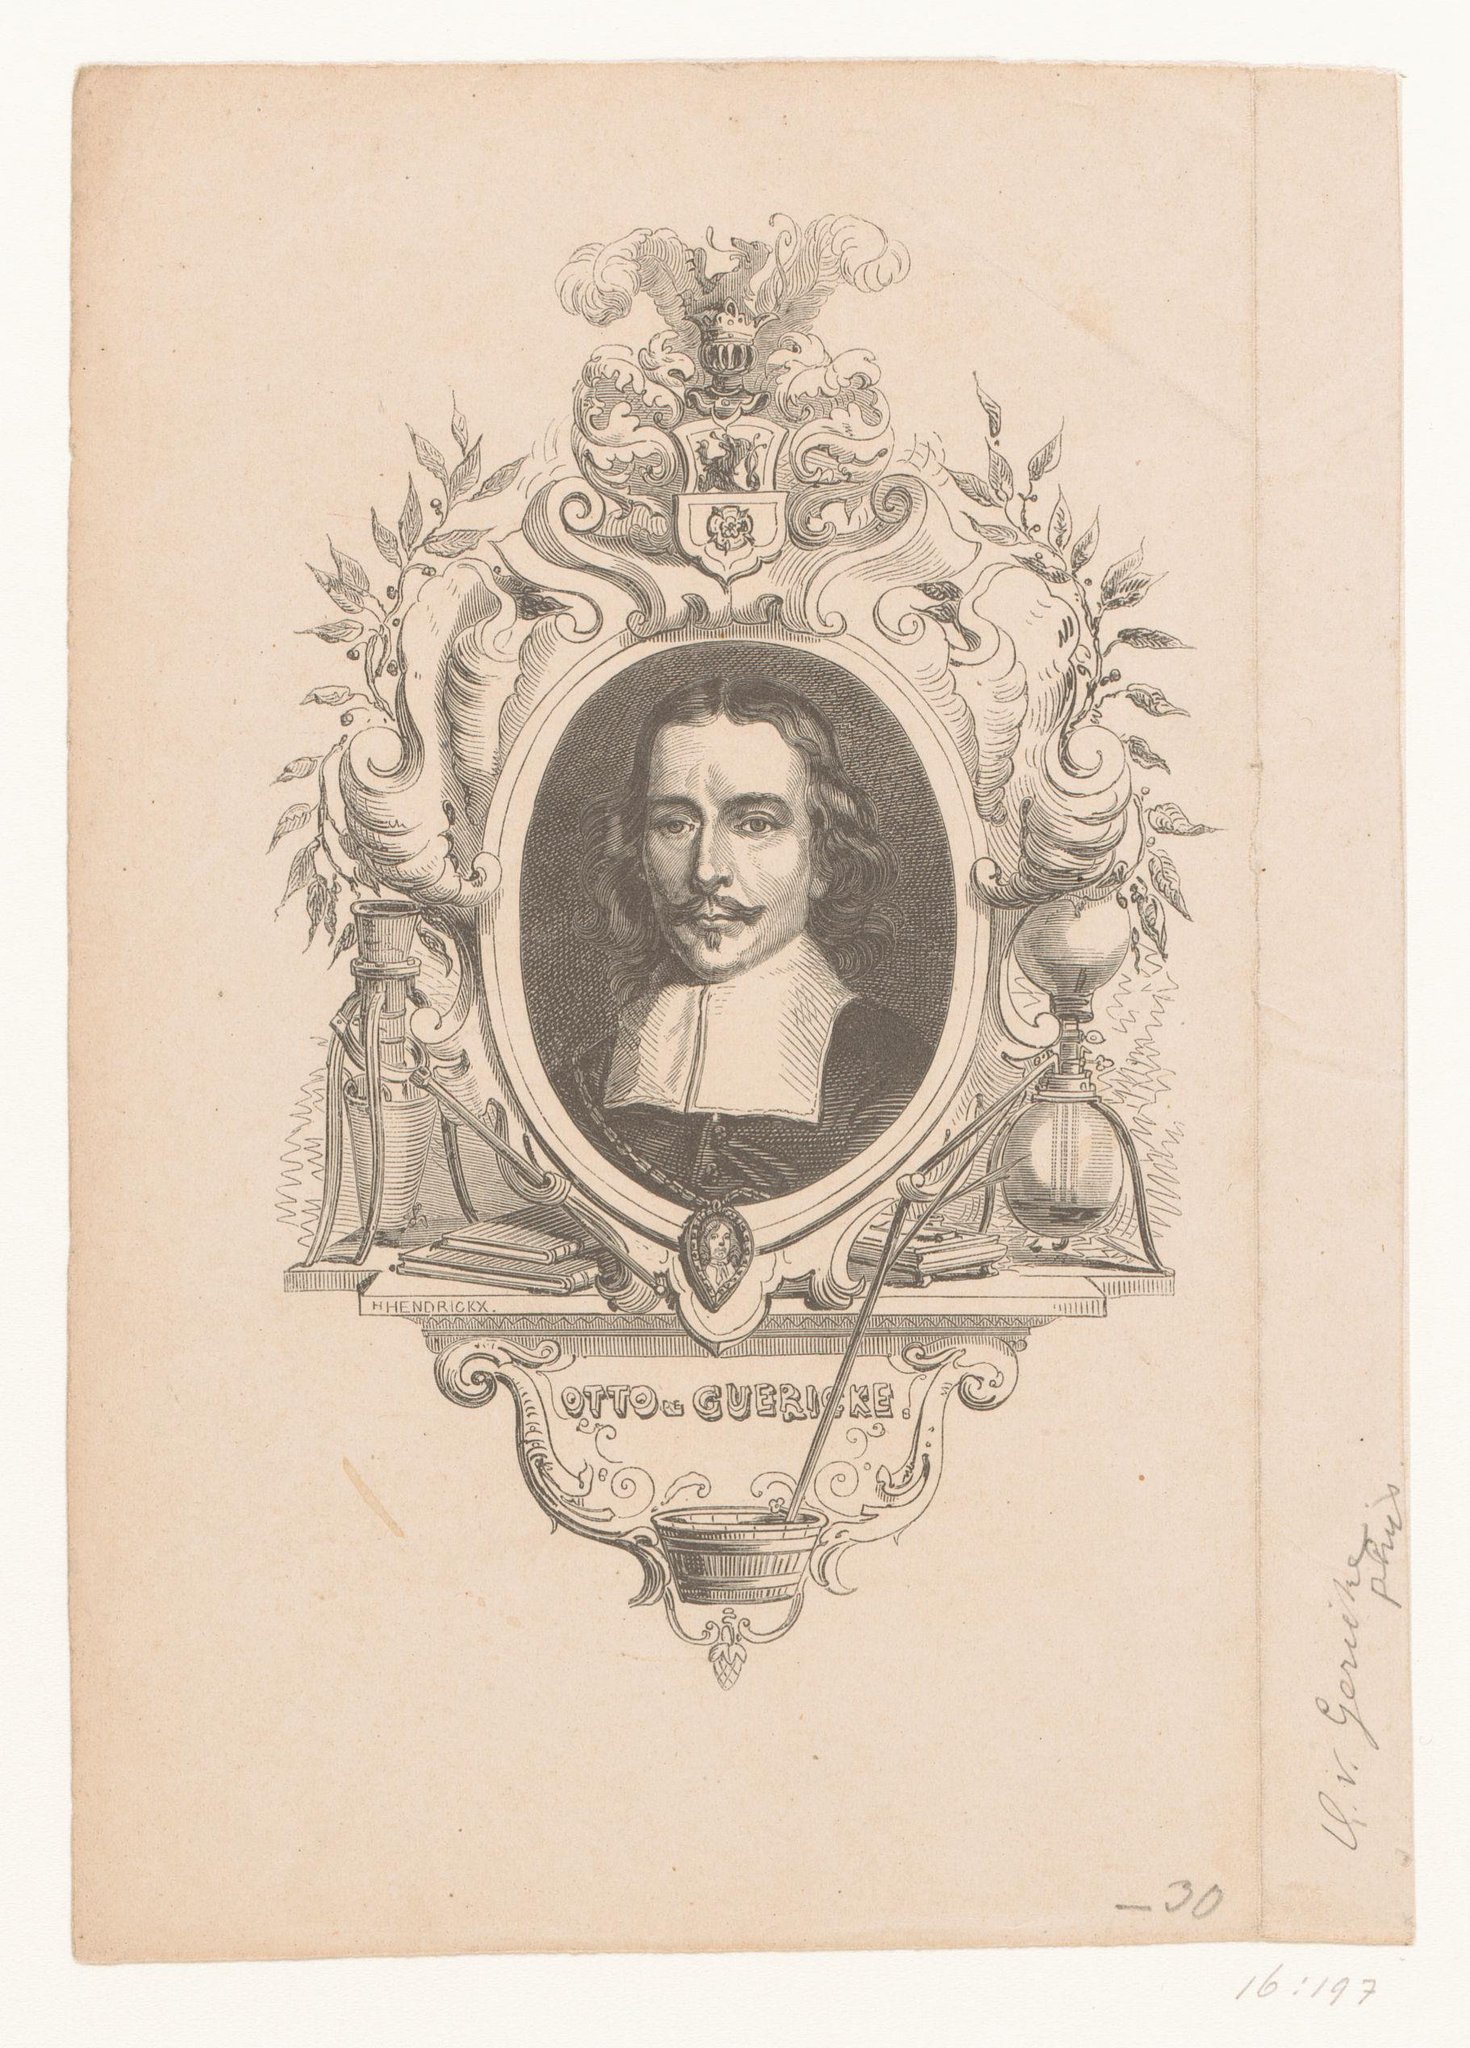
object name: print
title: Otto de Guericke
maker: henri hendrickx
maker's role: print maker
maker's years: 1817-1894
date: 1827-1894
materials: paper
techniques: engraving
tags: science and technology, moustache, adult man, historical persons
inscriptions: collector's mark: Lugt 2228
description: Otto Guericke was onder andere uitvinder van de vacuümpomp en de elektriseermachine. In het ornamentele kader is de pomp afgebeeld.